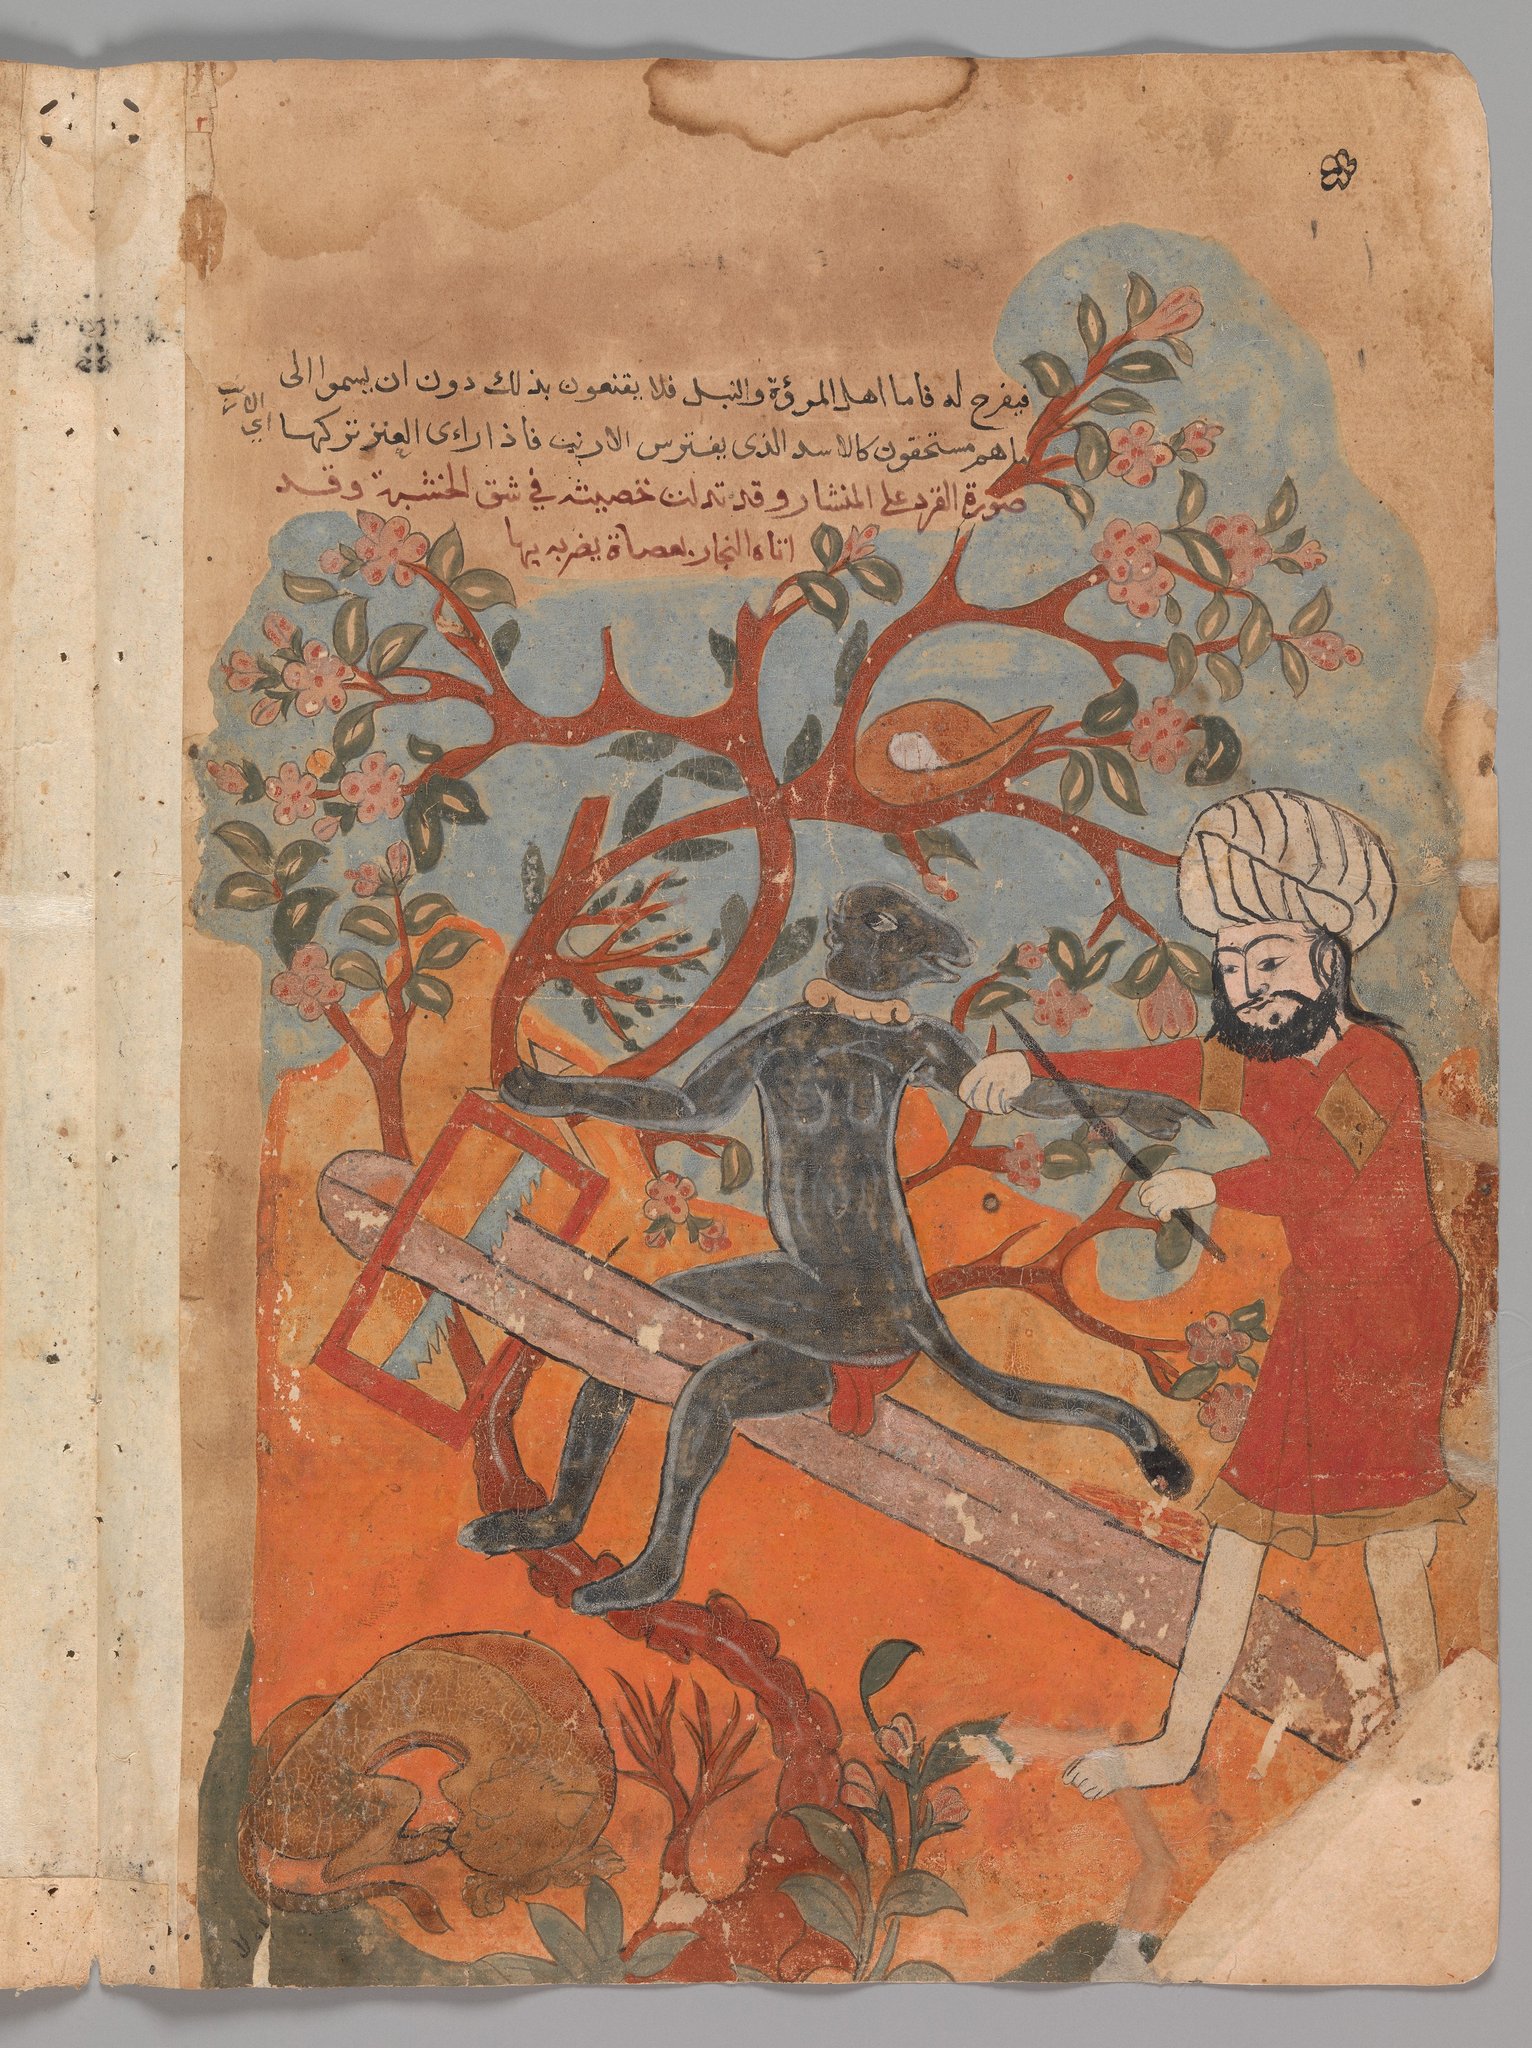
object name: folio from an illustrated manuscript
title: "The Monkey Tries Carpentry", Folio from a Kalila wa Dimna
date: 1526-1550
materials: ink, paper, watercolor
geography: india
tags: men,monkeys